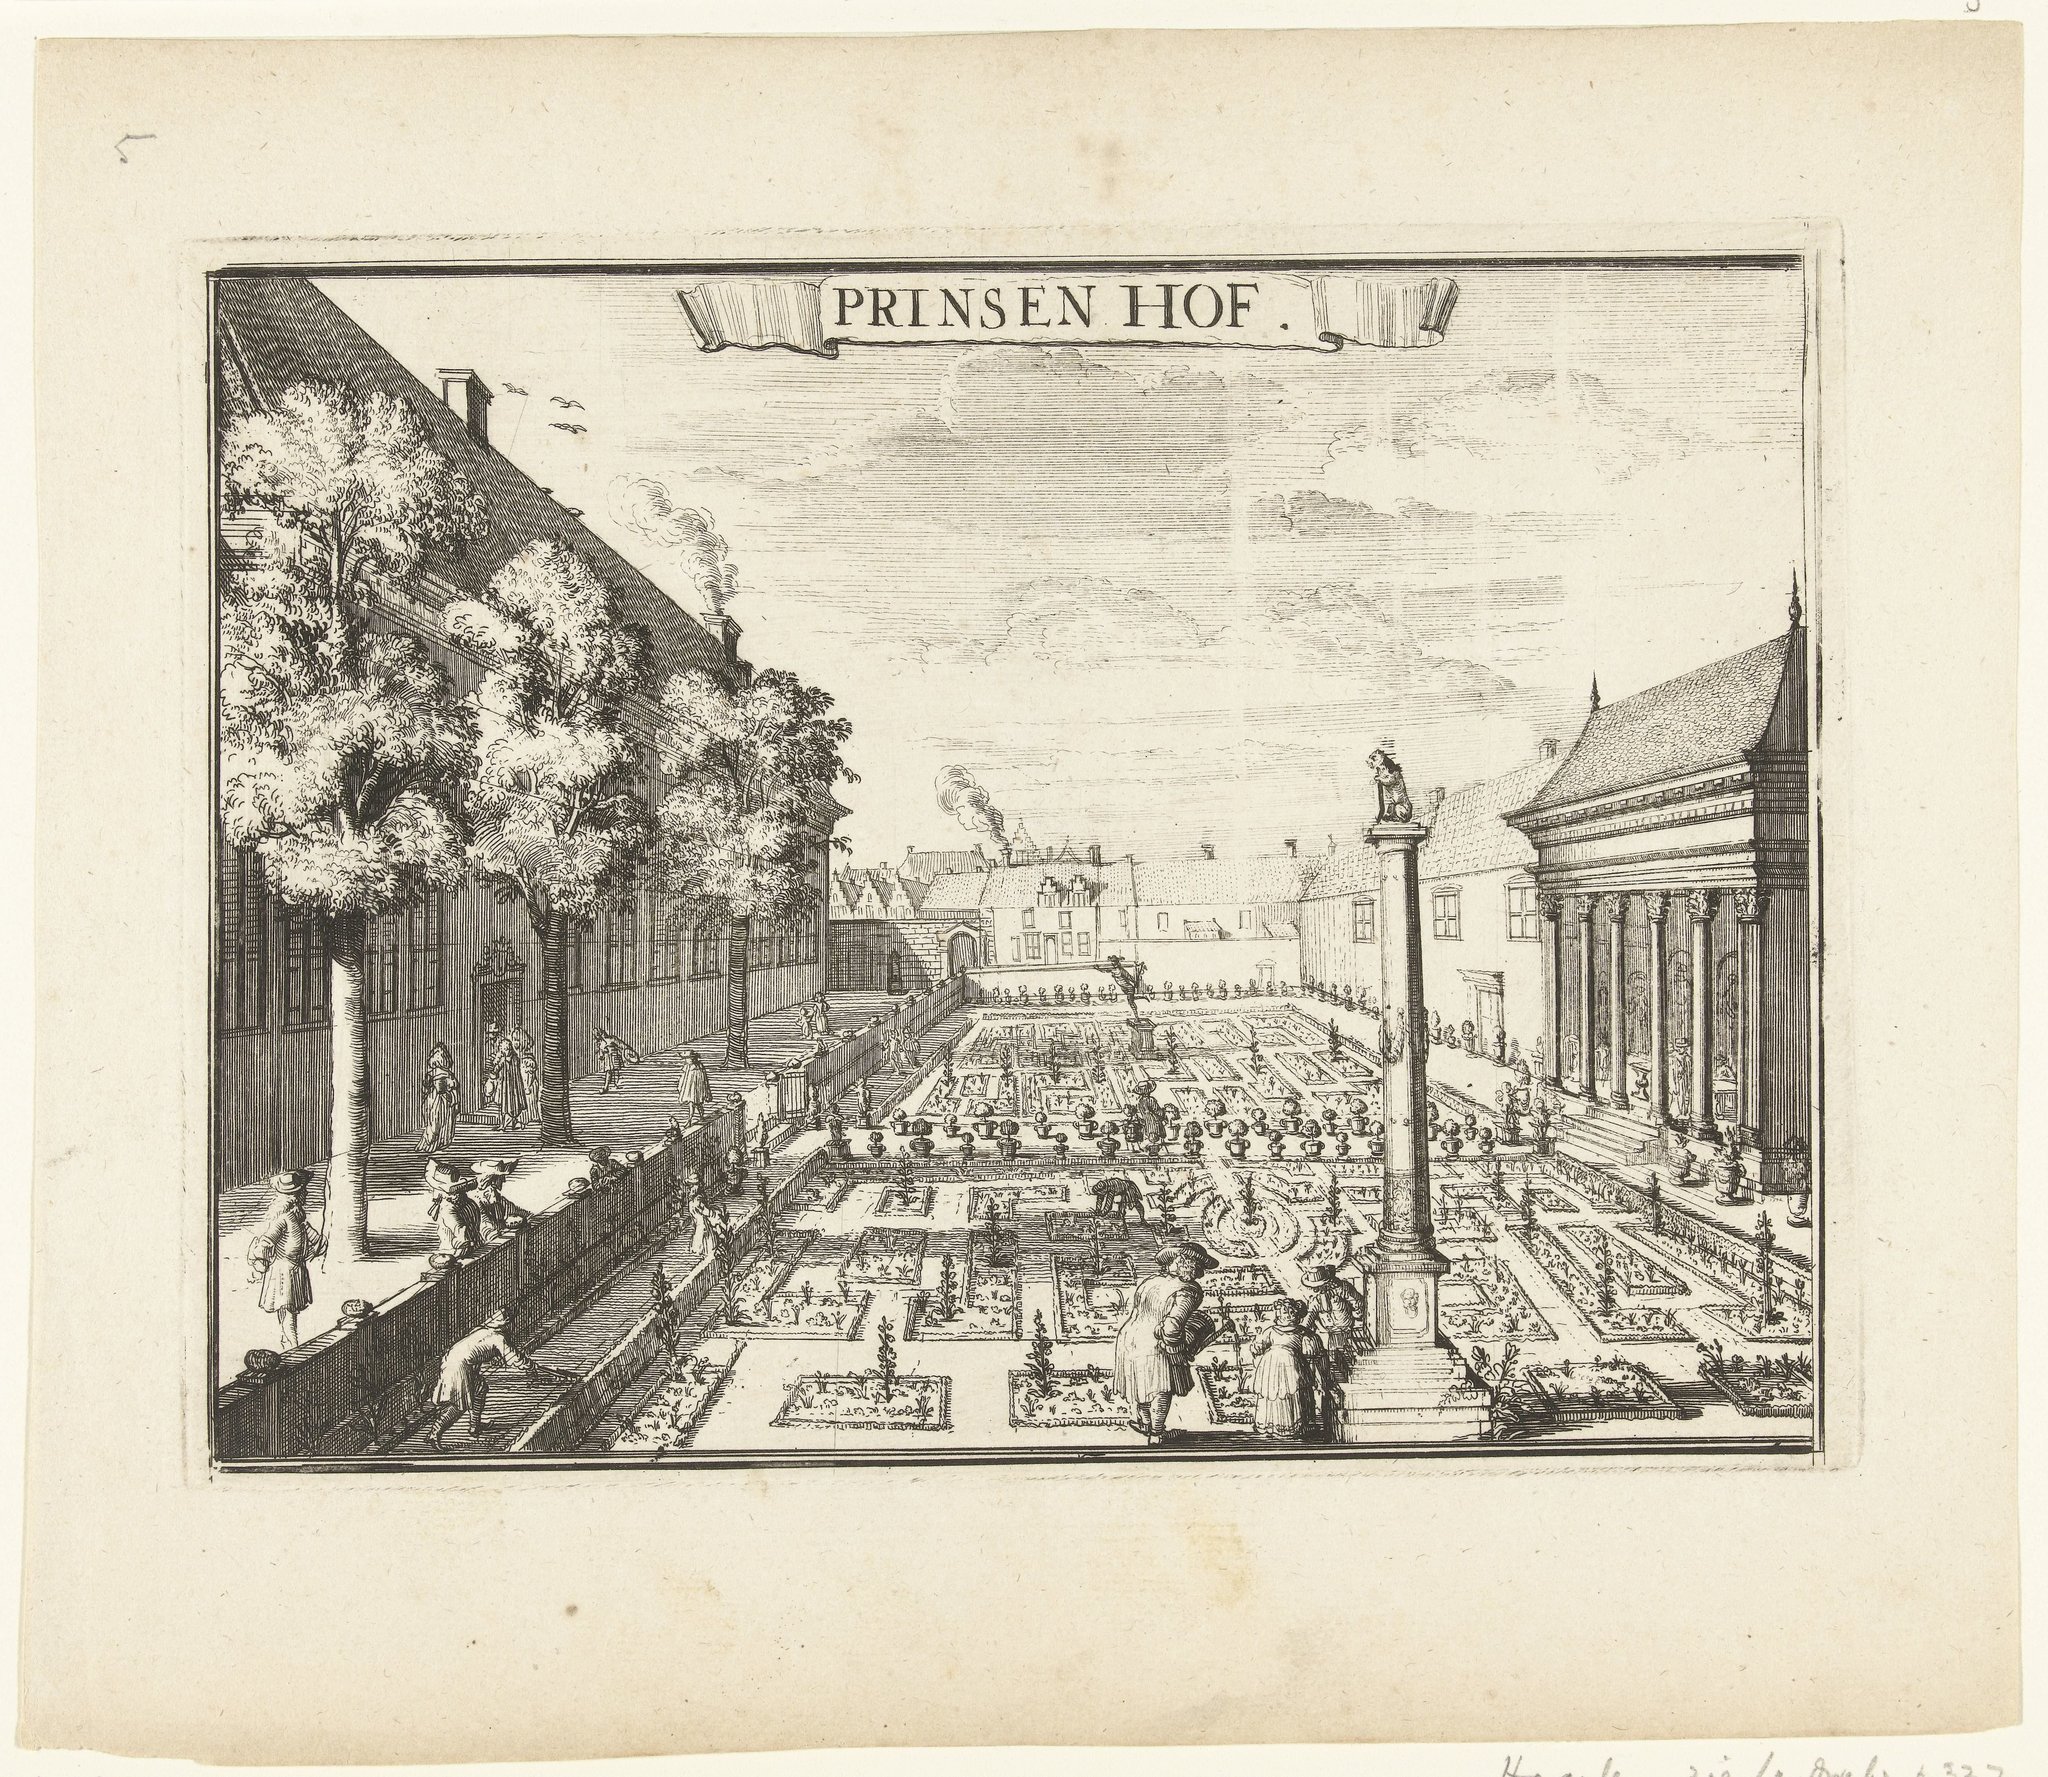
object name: print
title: Prinsen hof.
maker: romeyn de hooghe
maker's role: draughtsman, goldsmith, painter, print maker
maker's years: 1645-1708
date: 1688-1689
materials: paper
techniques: etching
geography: haarlem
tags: urban housing, garden, haarlem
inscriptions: collector's mark: Lugt 2228a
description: Gezicht op het Prinsenhof te Haarlem, met links enkele wandelaars en in de binnentuin enkele tuinmannen. Dit blad maakt deel uit van een omvangrijke prent met een grote plattegrond van Haarlem, omgeven door zeven wapenschilden, een profiel van de stad, gezichten op markante Haarlemse gebouwen en voorstellingen van belangrijke momenten uit de Haarlemse geschiedenis.